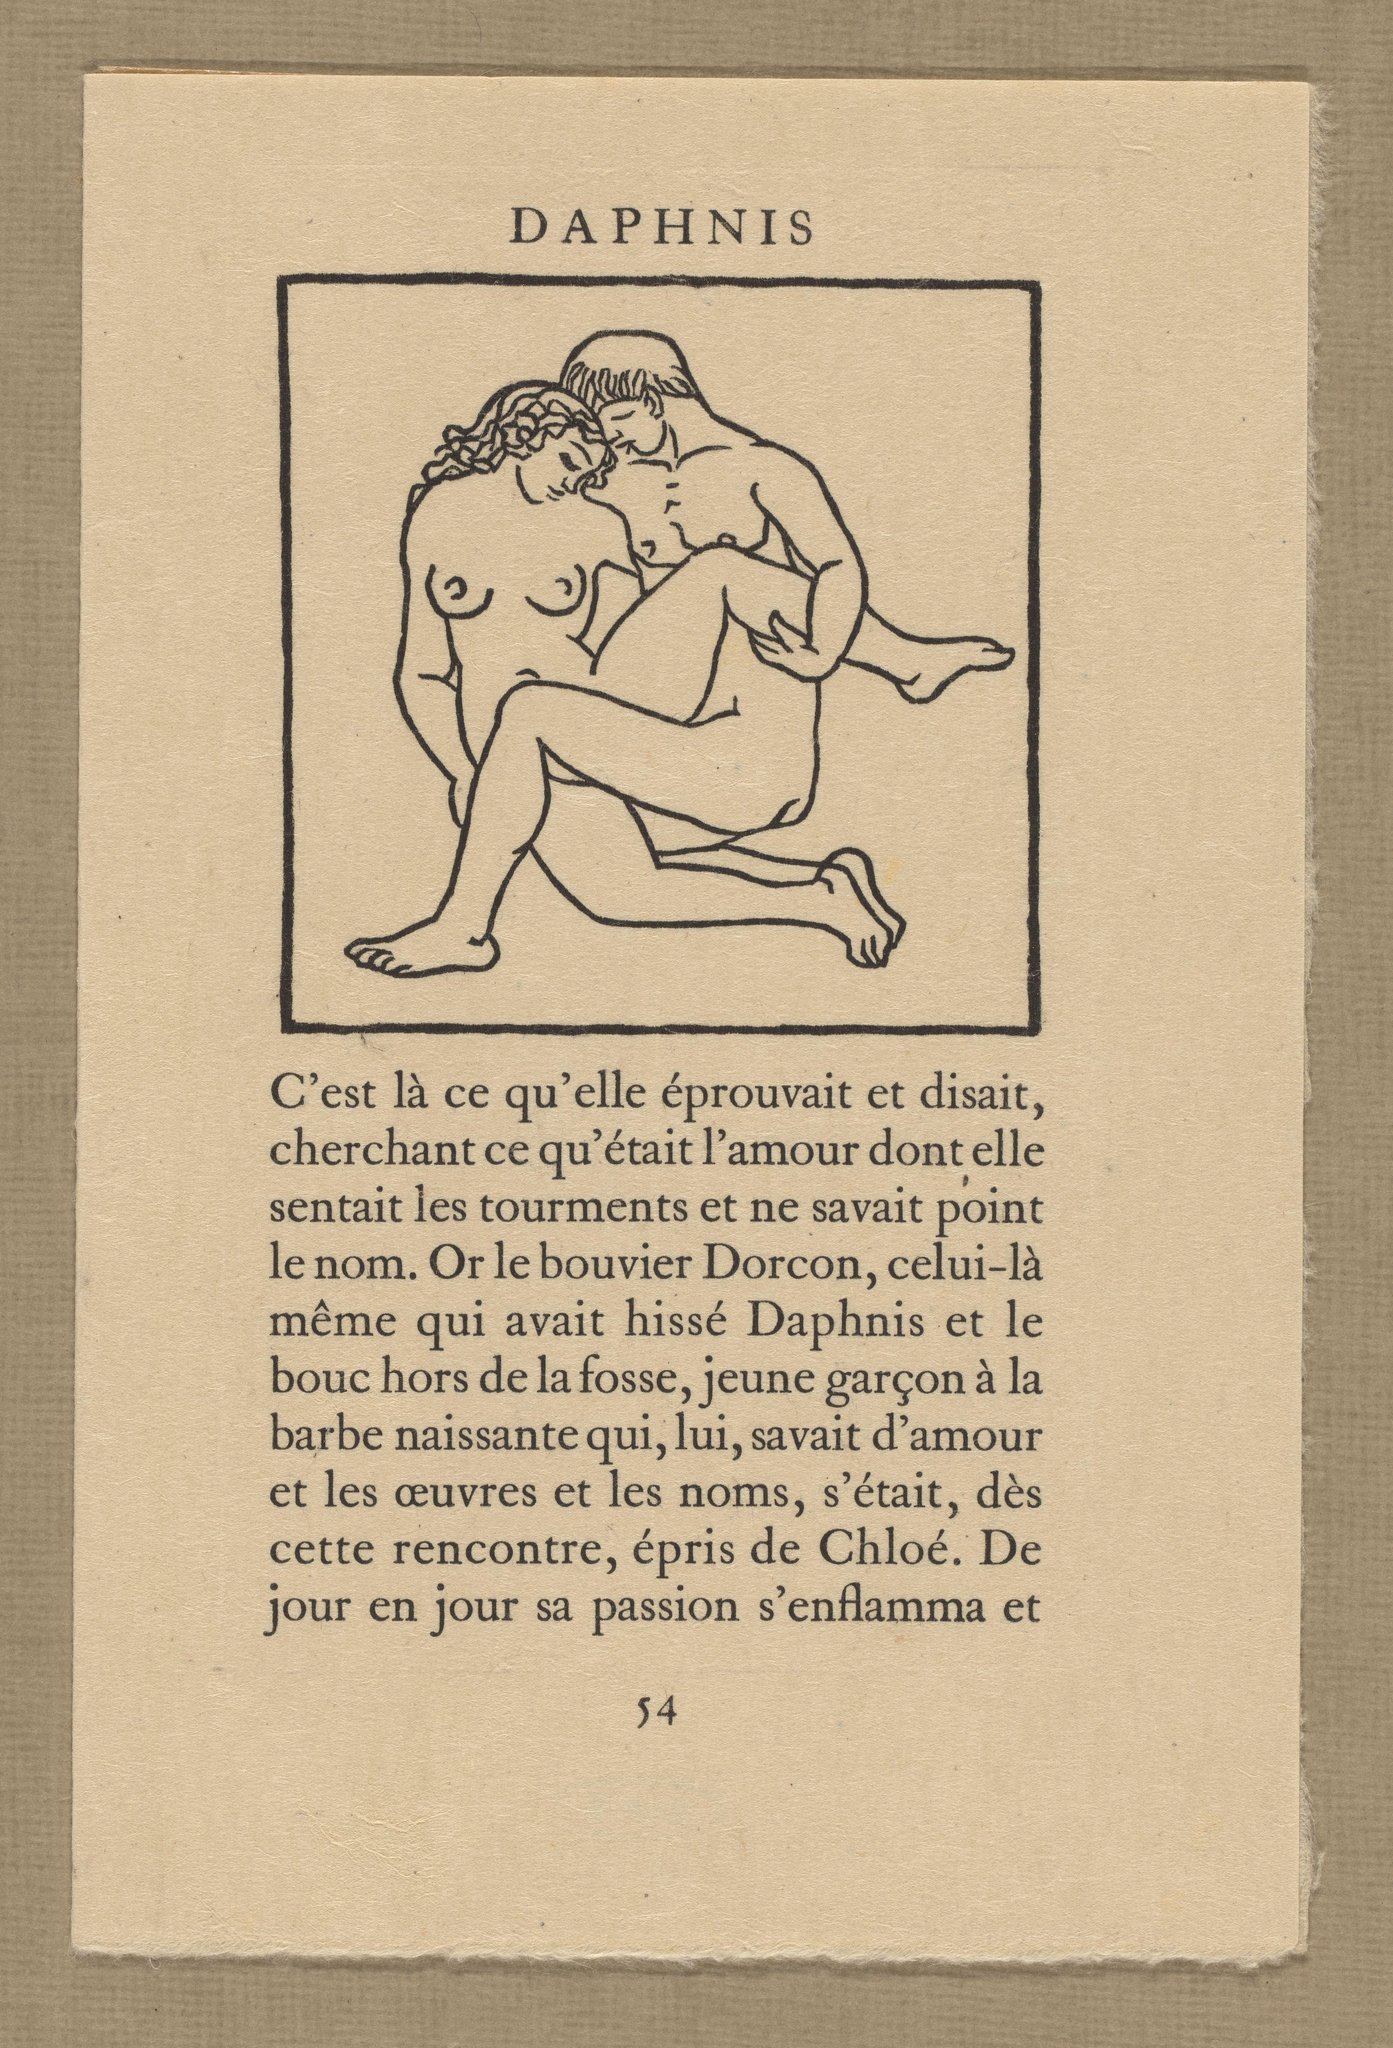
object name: print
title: Vrijend paar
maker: aristide maillol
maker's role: draughtsman, painter, print maker, sculptor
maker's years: 1861-1944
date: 1935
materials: paper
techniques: letterpress printing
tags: couple of lovers, coitus, cohabiting, sexual intercourse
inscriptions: collector's mark: Lugt 2228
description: Proefdruk van de prent gebruikt in: Ovidius Oublius Naso. L'art d'aimer. Parijs: Émile Charmontin, 1935, p. 122. Dat het in dit geval om een proefdruk gaat blijkt uit het feit dat de tekst een pagina uit 'Daphnis en Chloé' is, een andere publicatie waarvoor Maillol de afbeeldingen verzorgde in houtsnede (zie RP-P-1949-451-1 t/m 37).